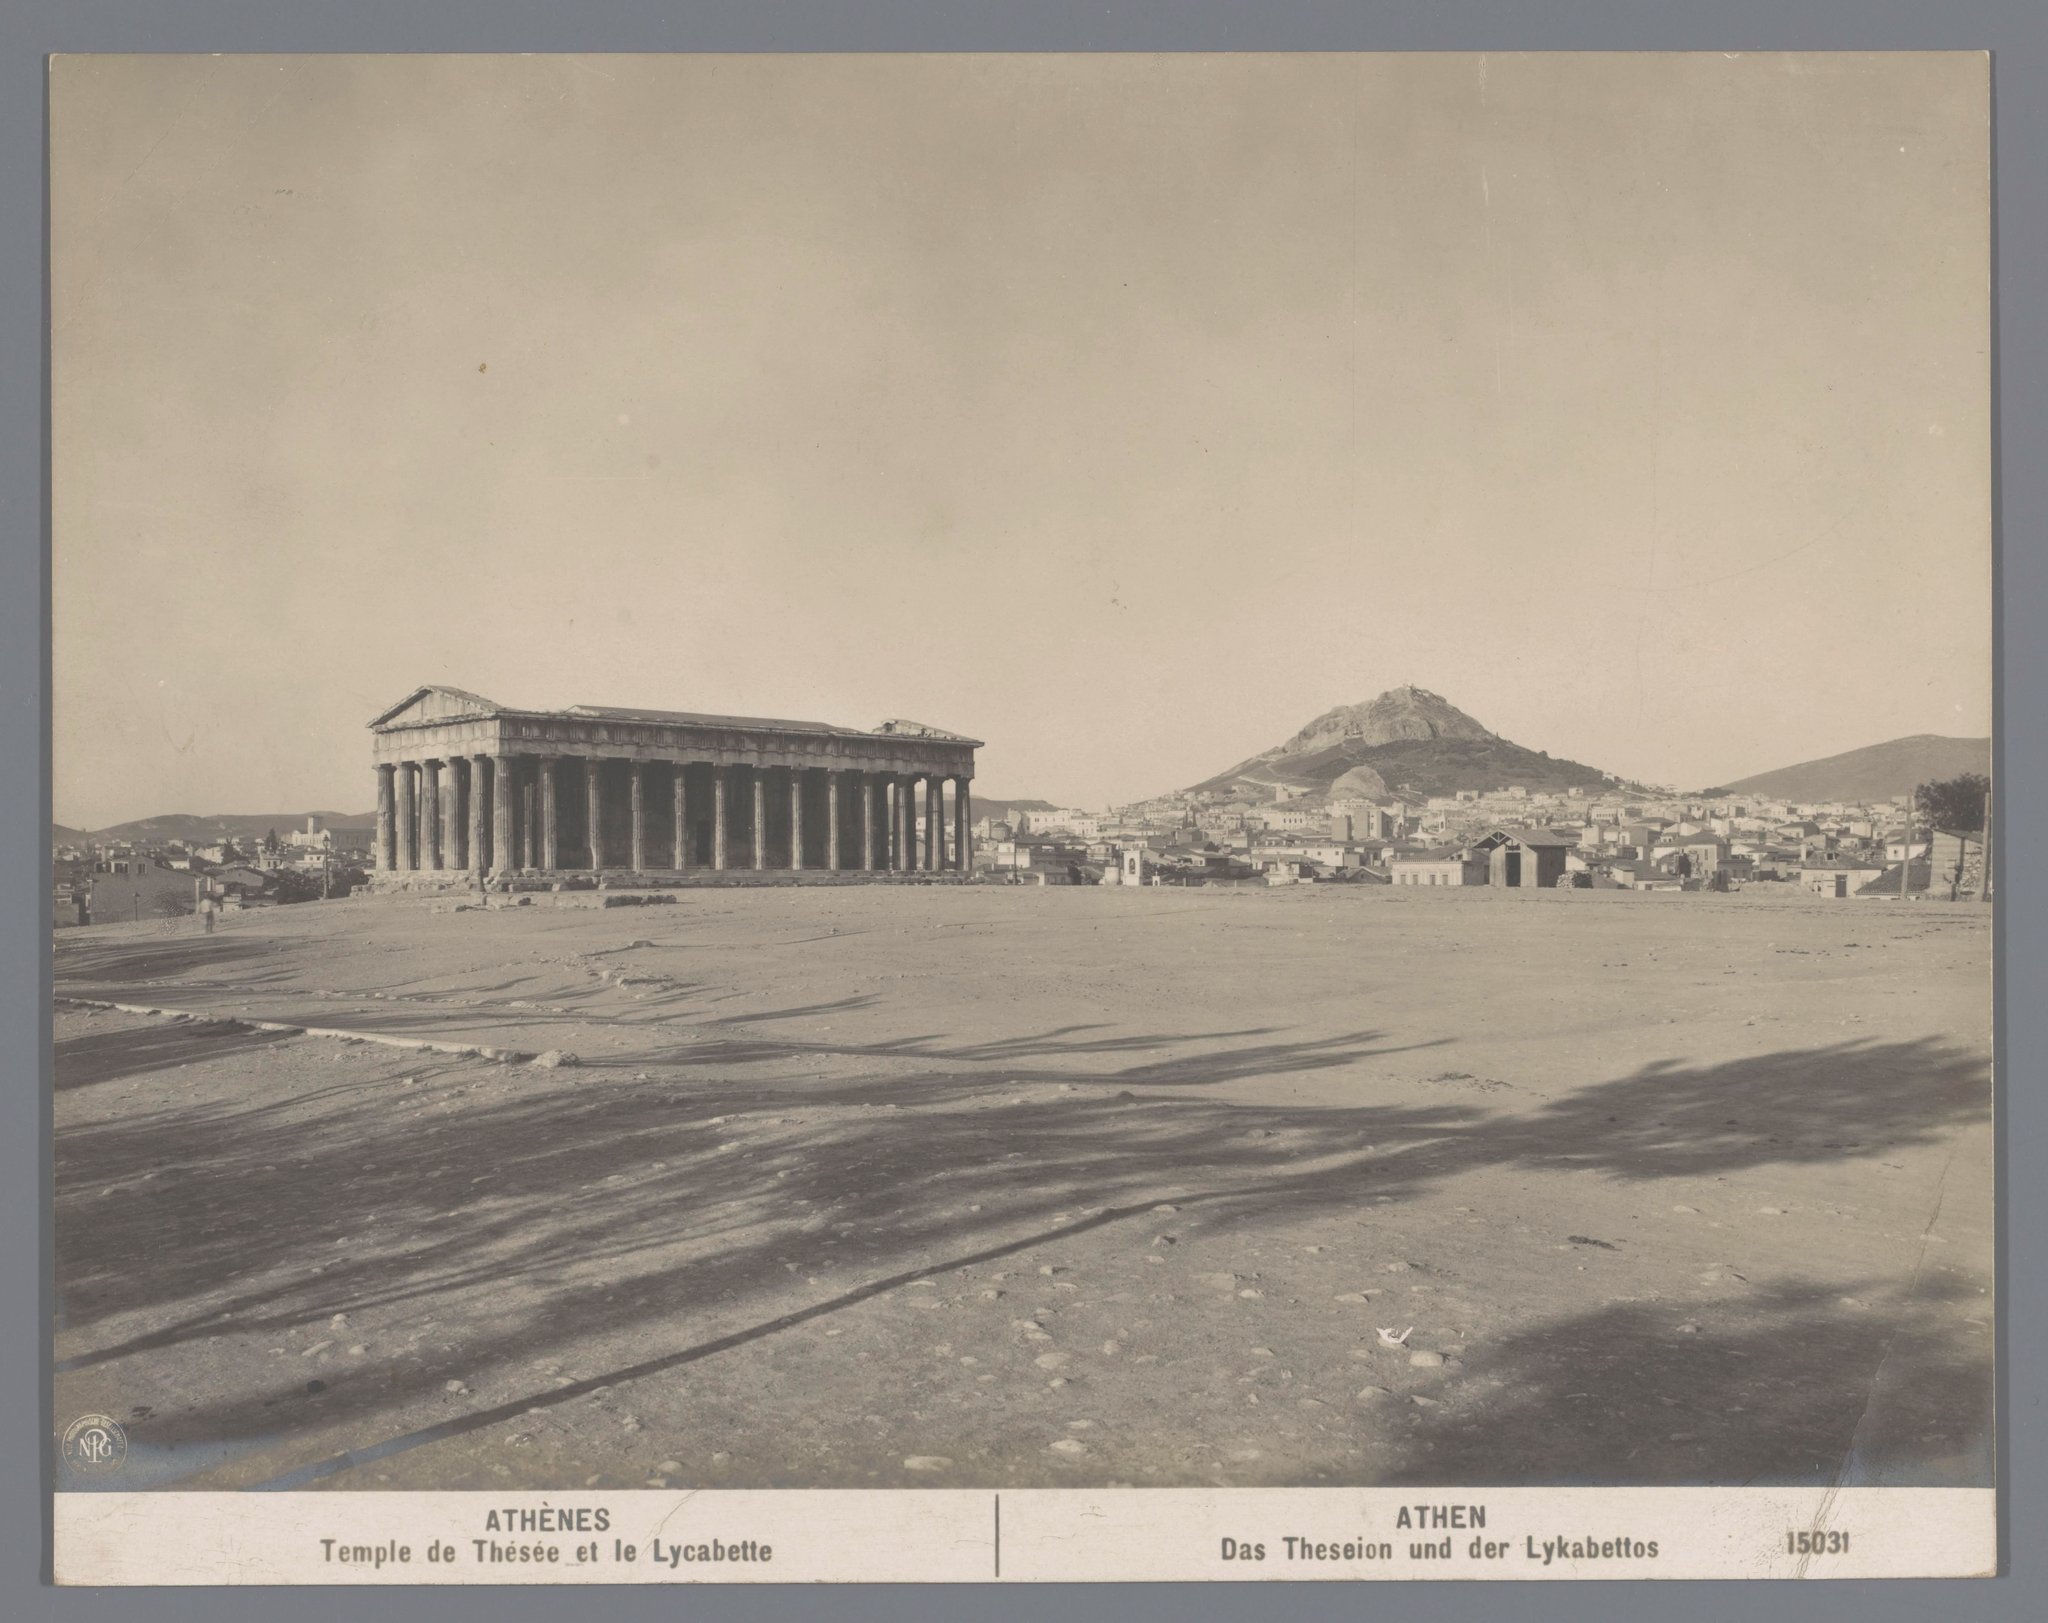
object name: photograph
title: Tempel van Hephaistos en de Lykabettos te Athene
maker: Anonymous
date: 1905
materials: paper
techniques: gelatin silver print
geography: steglitz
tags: landscape with ruins, temple, shrine ~ greek religion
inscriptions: number: ‘15031’, stamp: ‘II. WAHL’, inscription: ‘Neue Photographische Gesellschaft A.G./ Berlin Steglitz 1905/ NPG’, collector's mark: ‘Vosmaer’